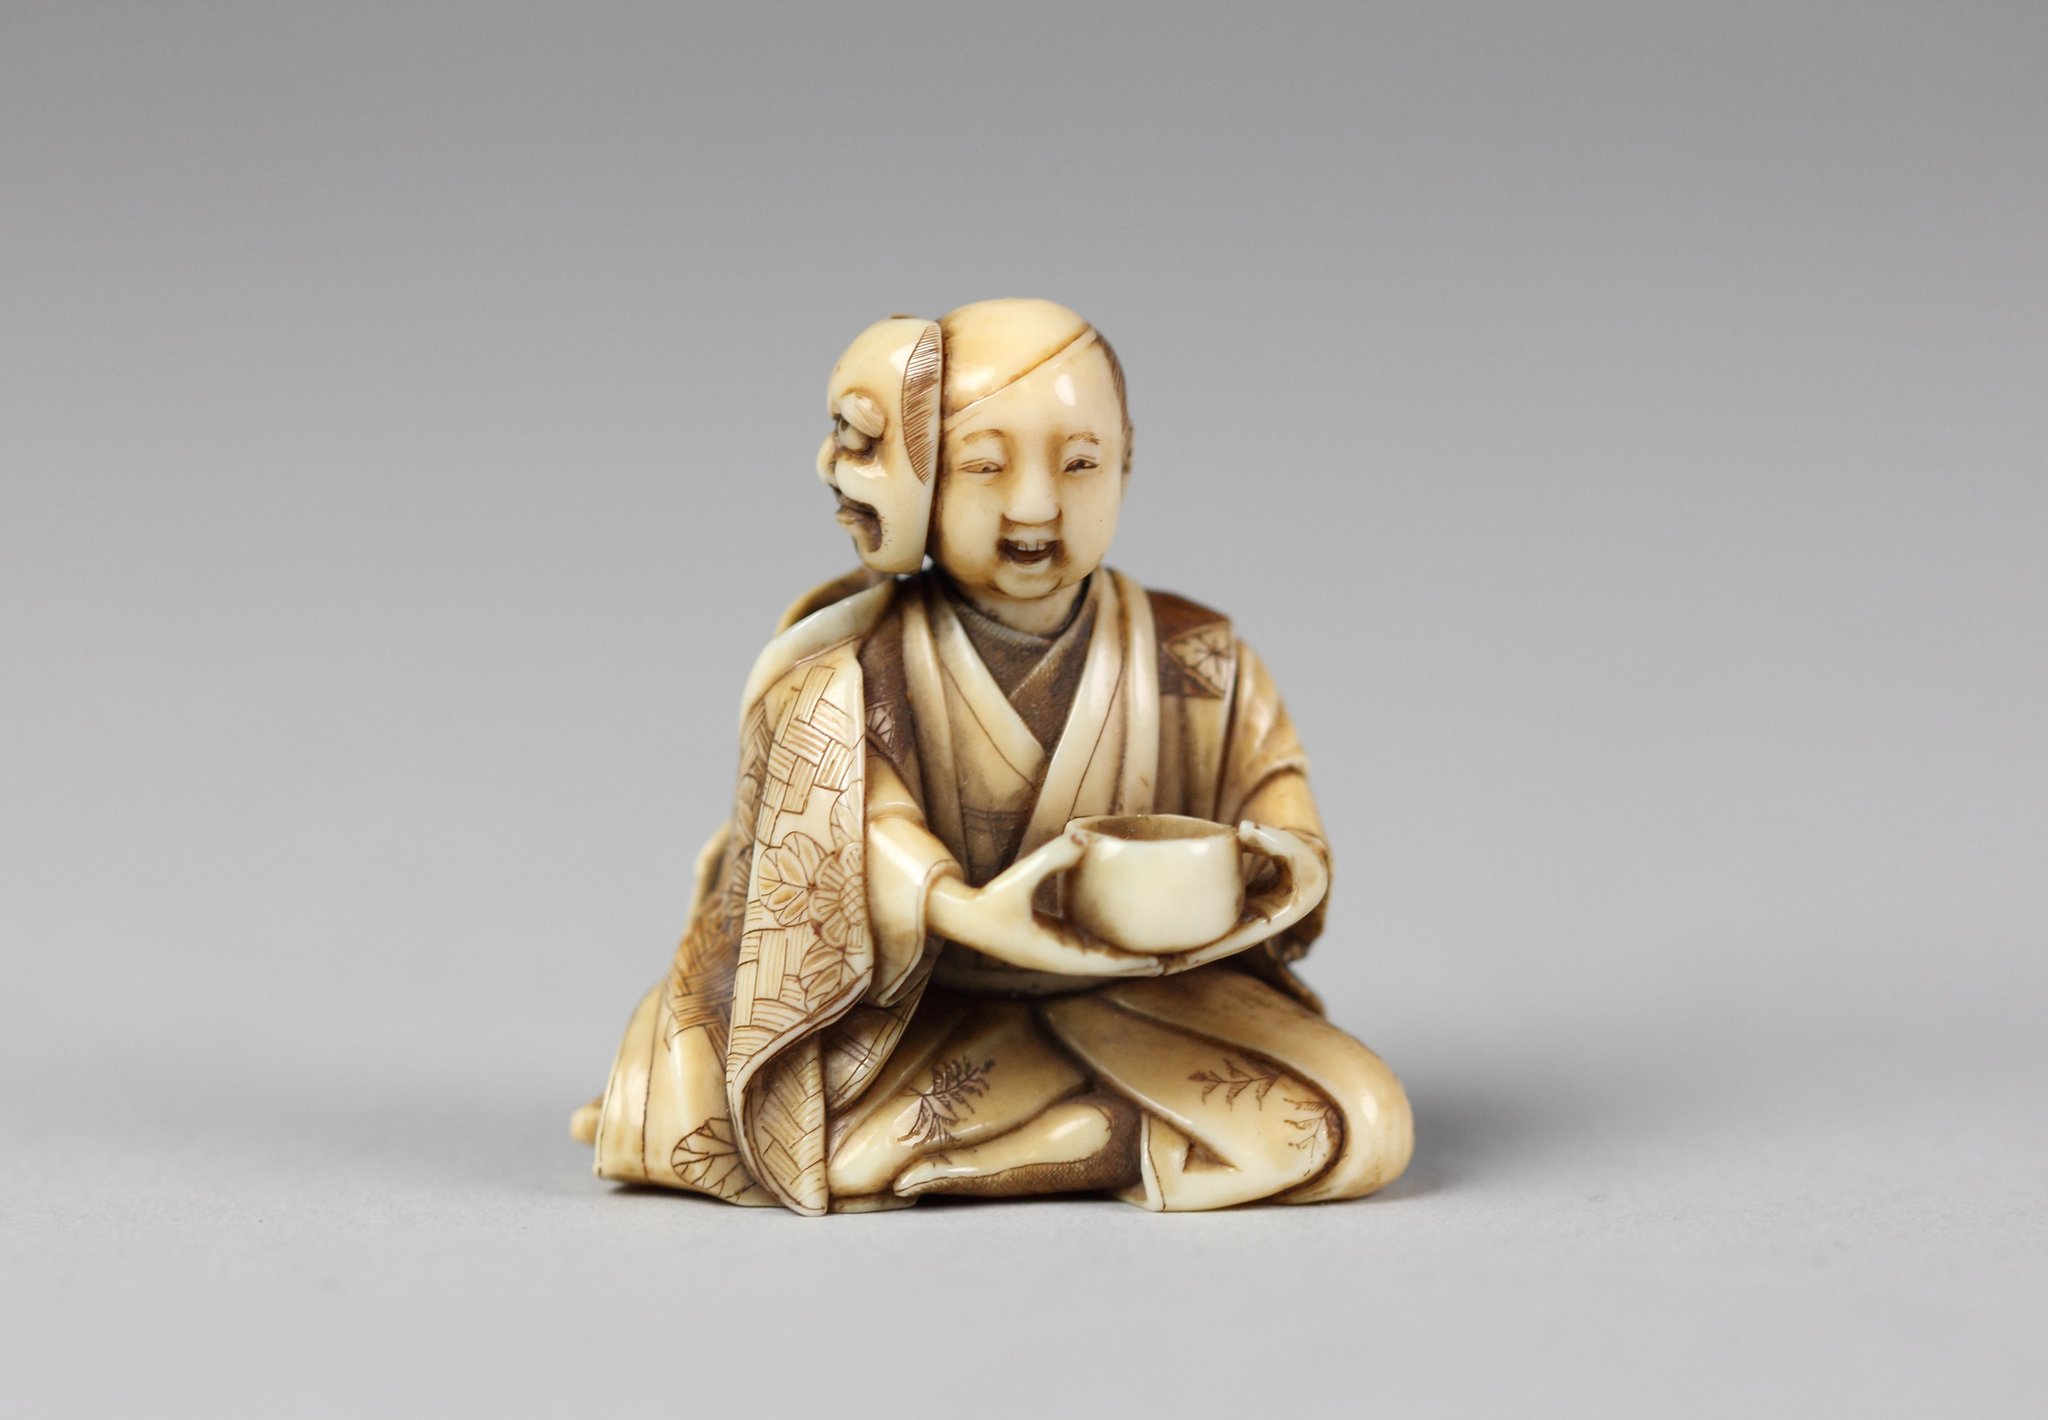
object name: netsuke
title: Netsuke of Obaga Saké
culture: japanese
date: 1767-1800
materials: ivory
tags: masks,men